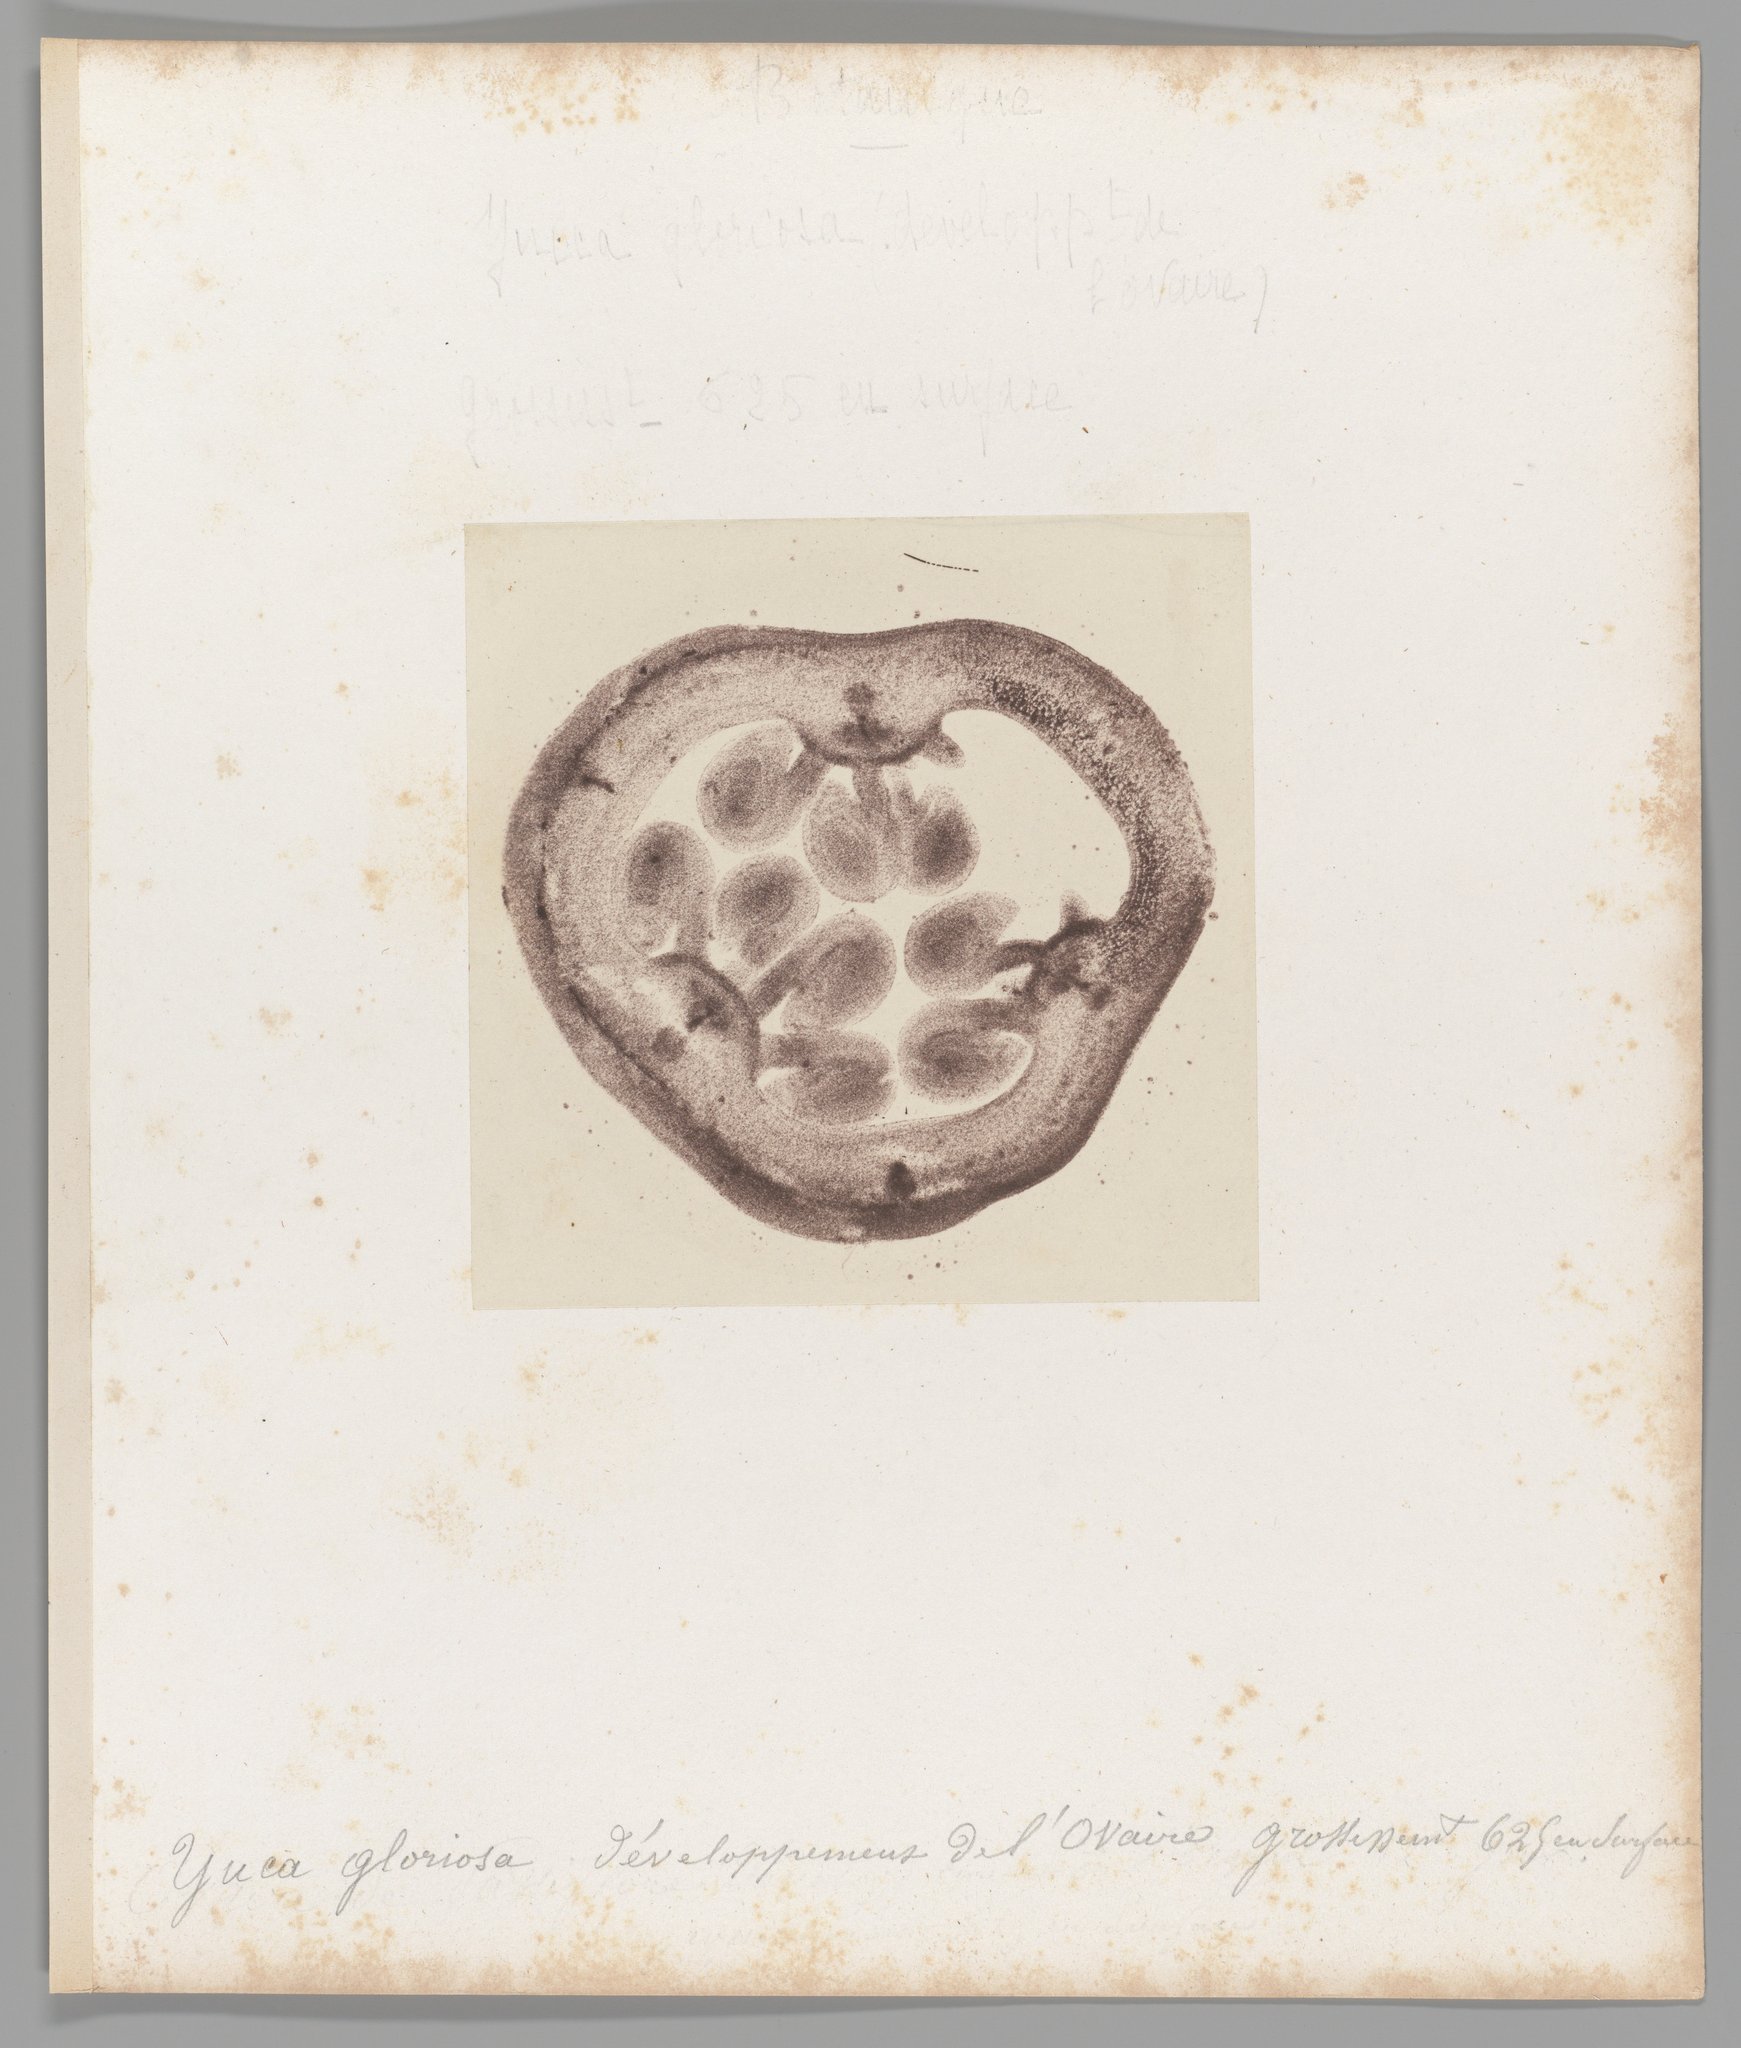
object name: photograph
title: [Untitled]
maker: auguste-adolphe bertsch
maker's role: artist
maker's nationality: french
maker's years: 1813-1871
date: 1853-1857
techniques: salted paper print